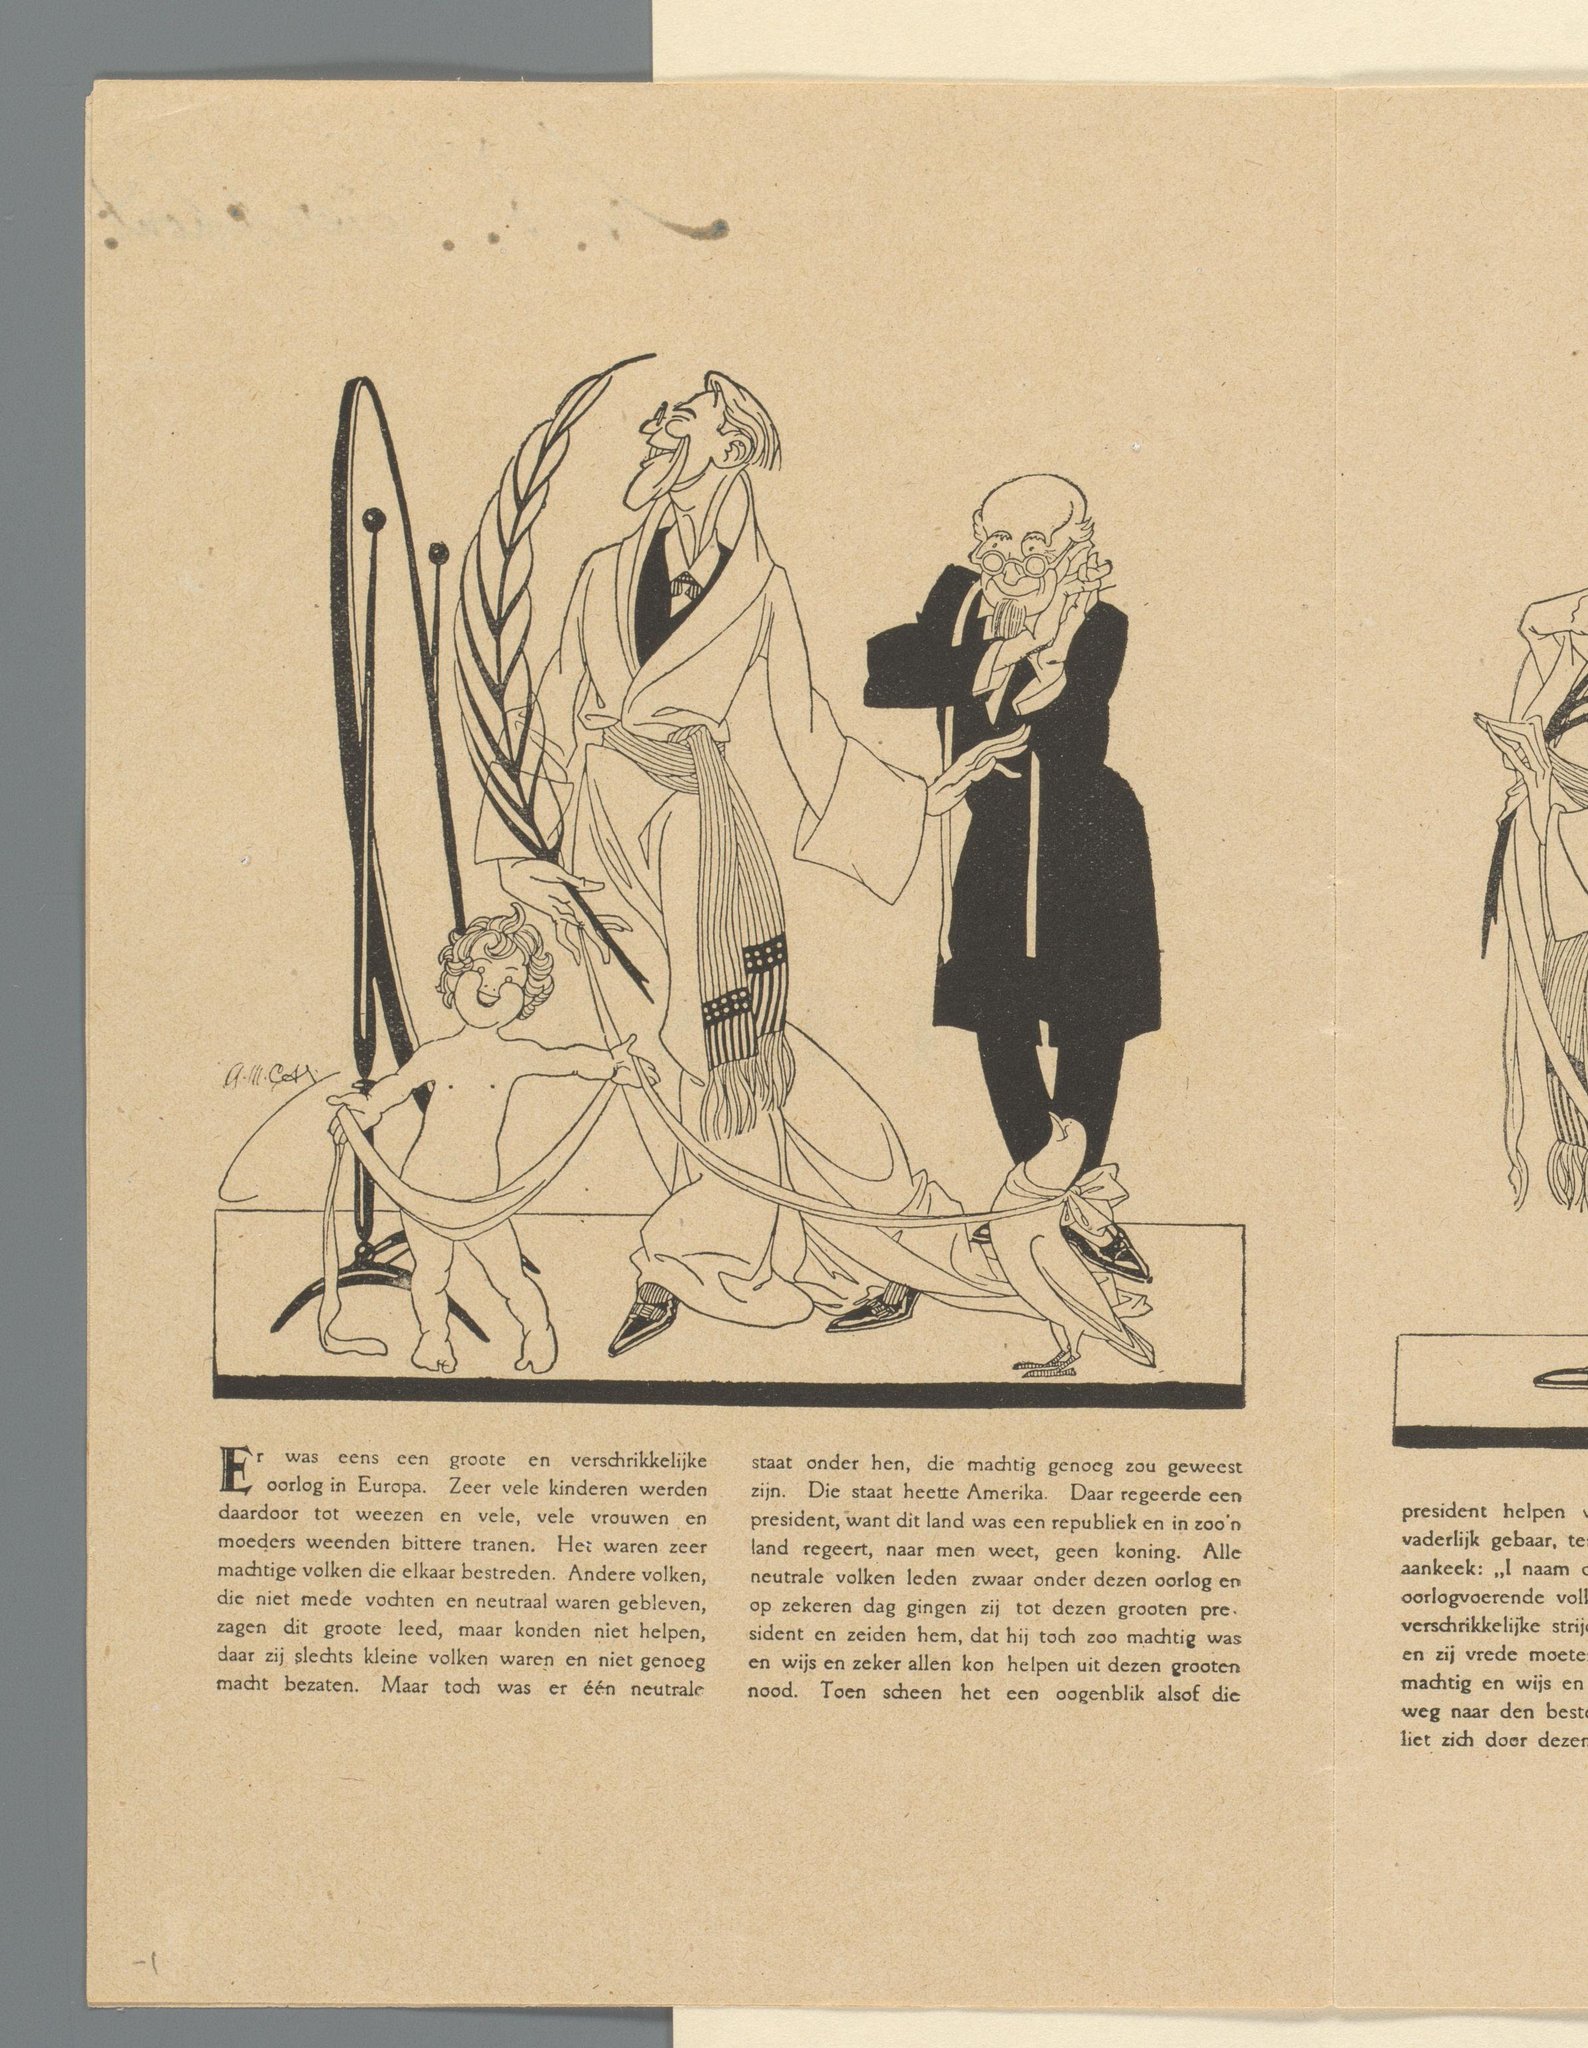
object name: book illustration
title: Woodrow Wilson met een palmtak voor een spiegel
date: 1917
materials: paper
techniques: printing block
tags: president ~ head of republic, political caricatures and satires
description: Prent uit: Cay, A.M. Wilson de menschenvriend; een modern sprookje. S.l.: s.n., ca. 1917.